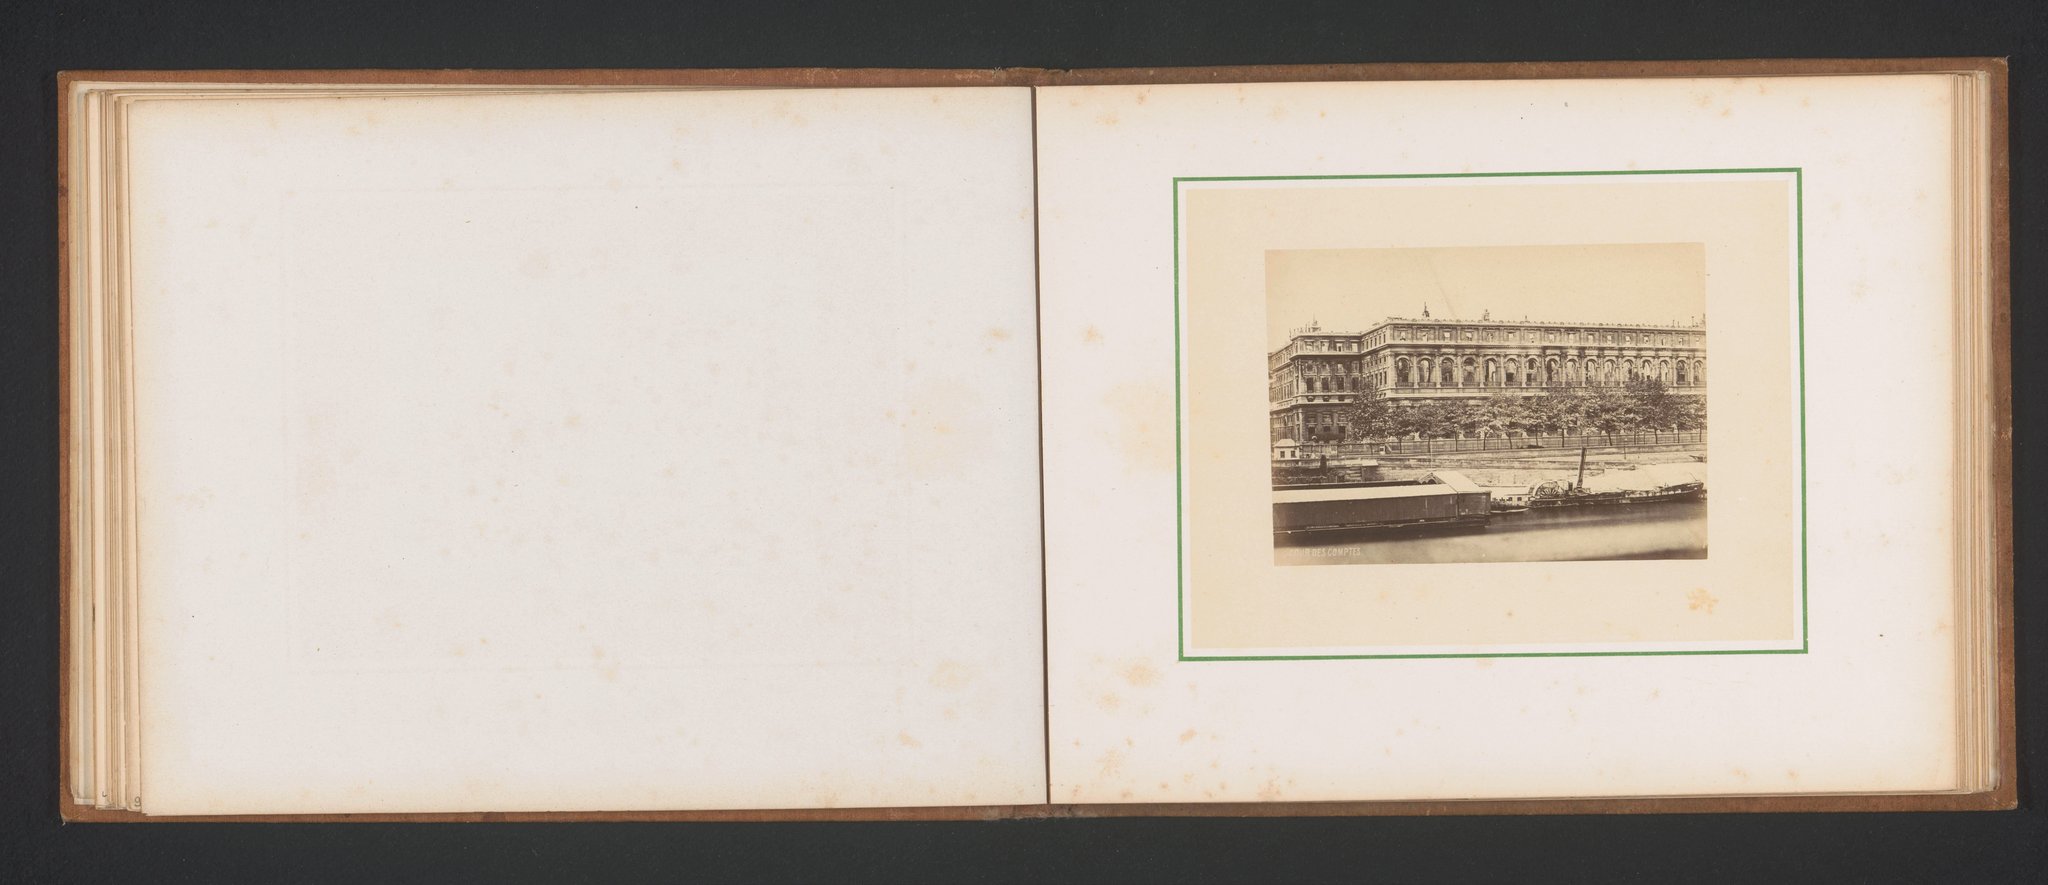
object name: photograph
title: Cour des Comptes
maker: p. loubère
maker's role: fotograaf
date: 1871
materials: photographic support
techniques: albumen print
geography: paris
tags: ruin of a building ~ architecture, national government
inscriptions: monogram: ‘P[.L.]’